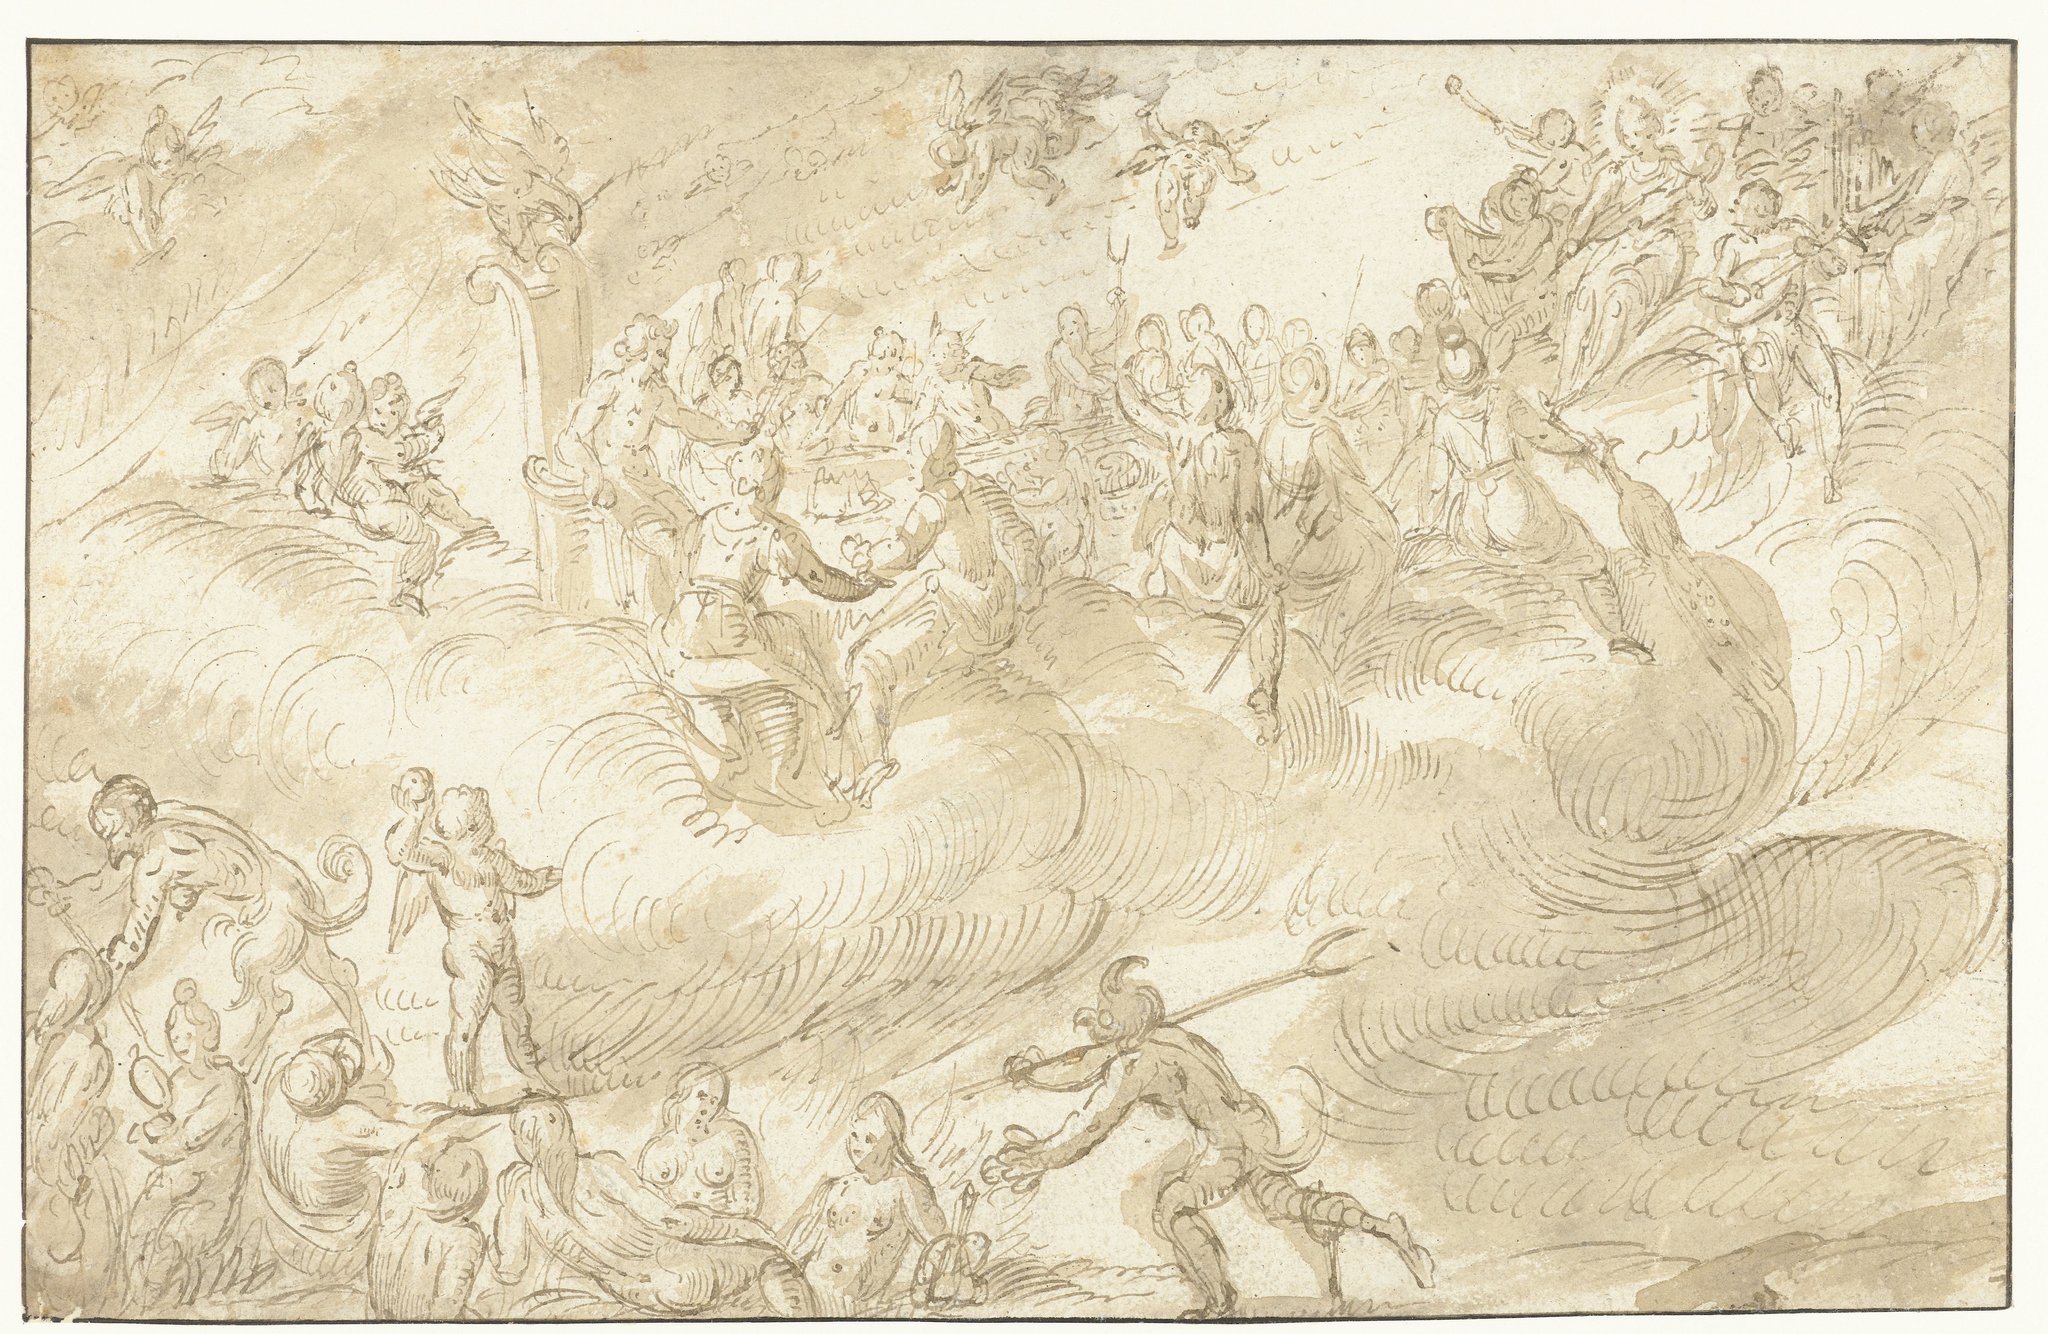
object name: drawing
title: Godenmaaltijd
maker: jacob isaacsz. van swanenburg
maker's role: draughtsman, painter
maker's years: 1571-1638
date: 1581-1638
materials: ink, paper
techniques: brush, pen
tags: banquets, feasts of the gods (in the air, possibly on the clouds), representations of hell (with the damned and devils), usually with burning fires, the seven deadly sins (personified), eris throws the golden apple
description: Godenmaaltijd; links onderaan de Zeven Hoofdzonden in de hel.